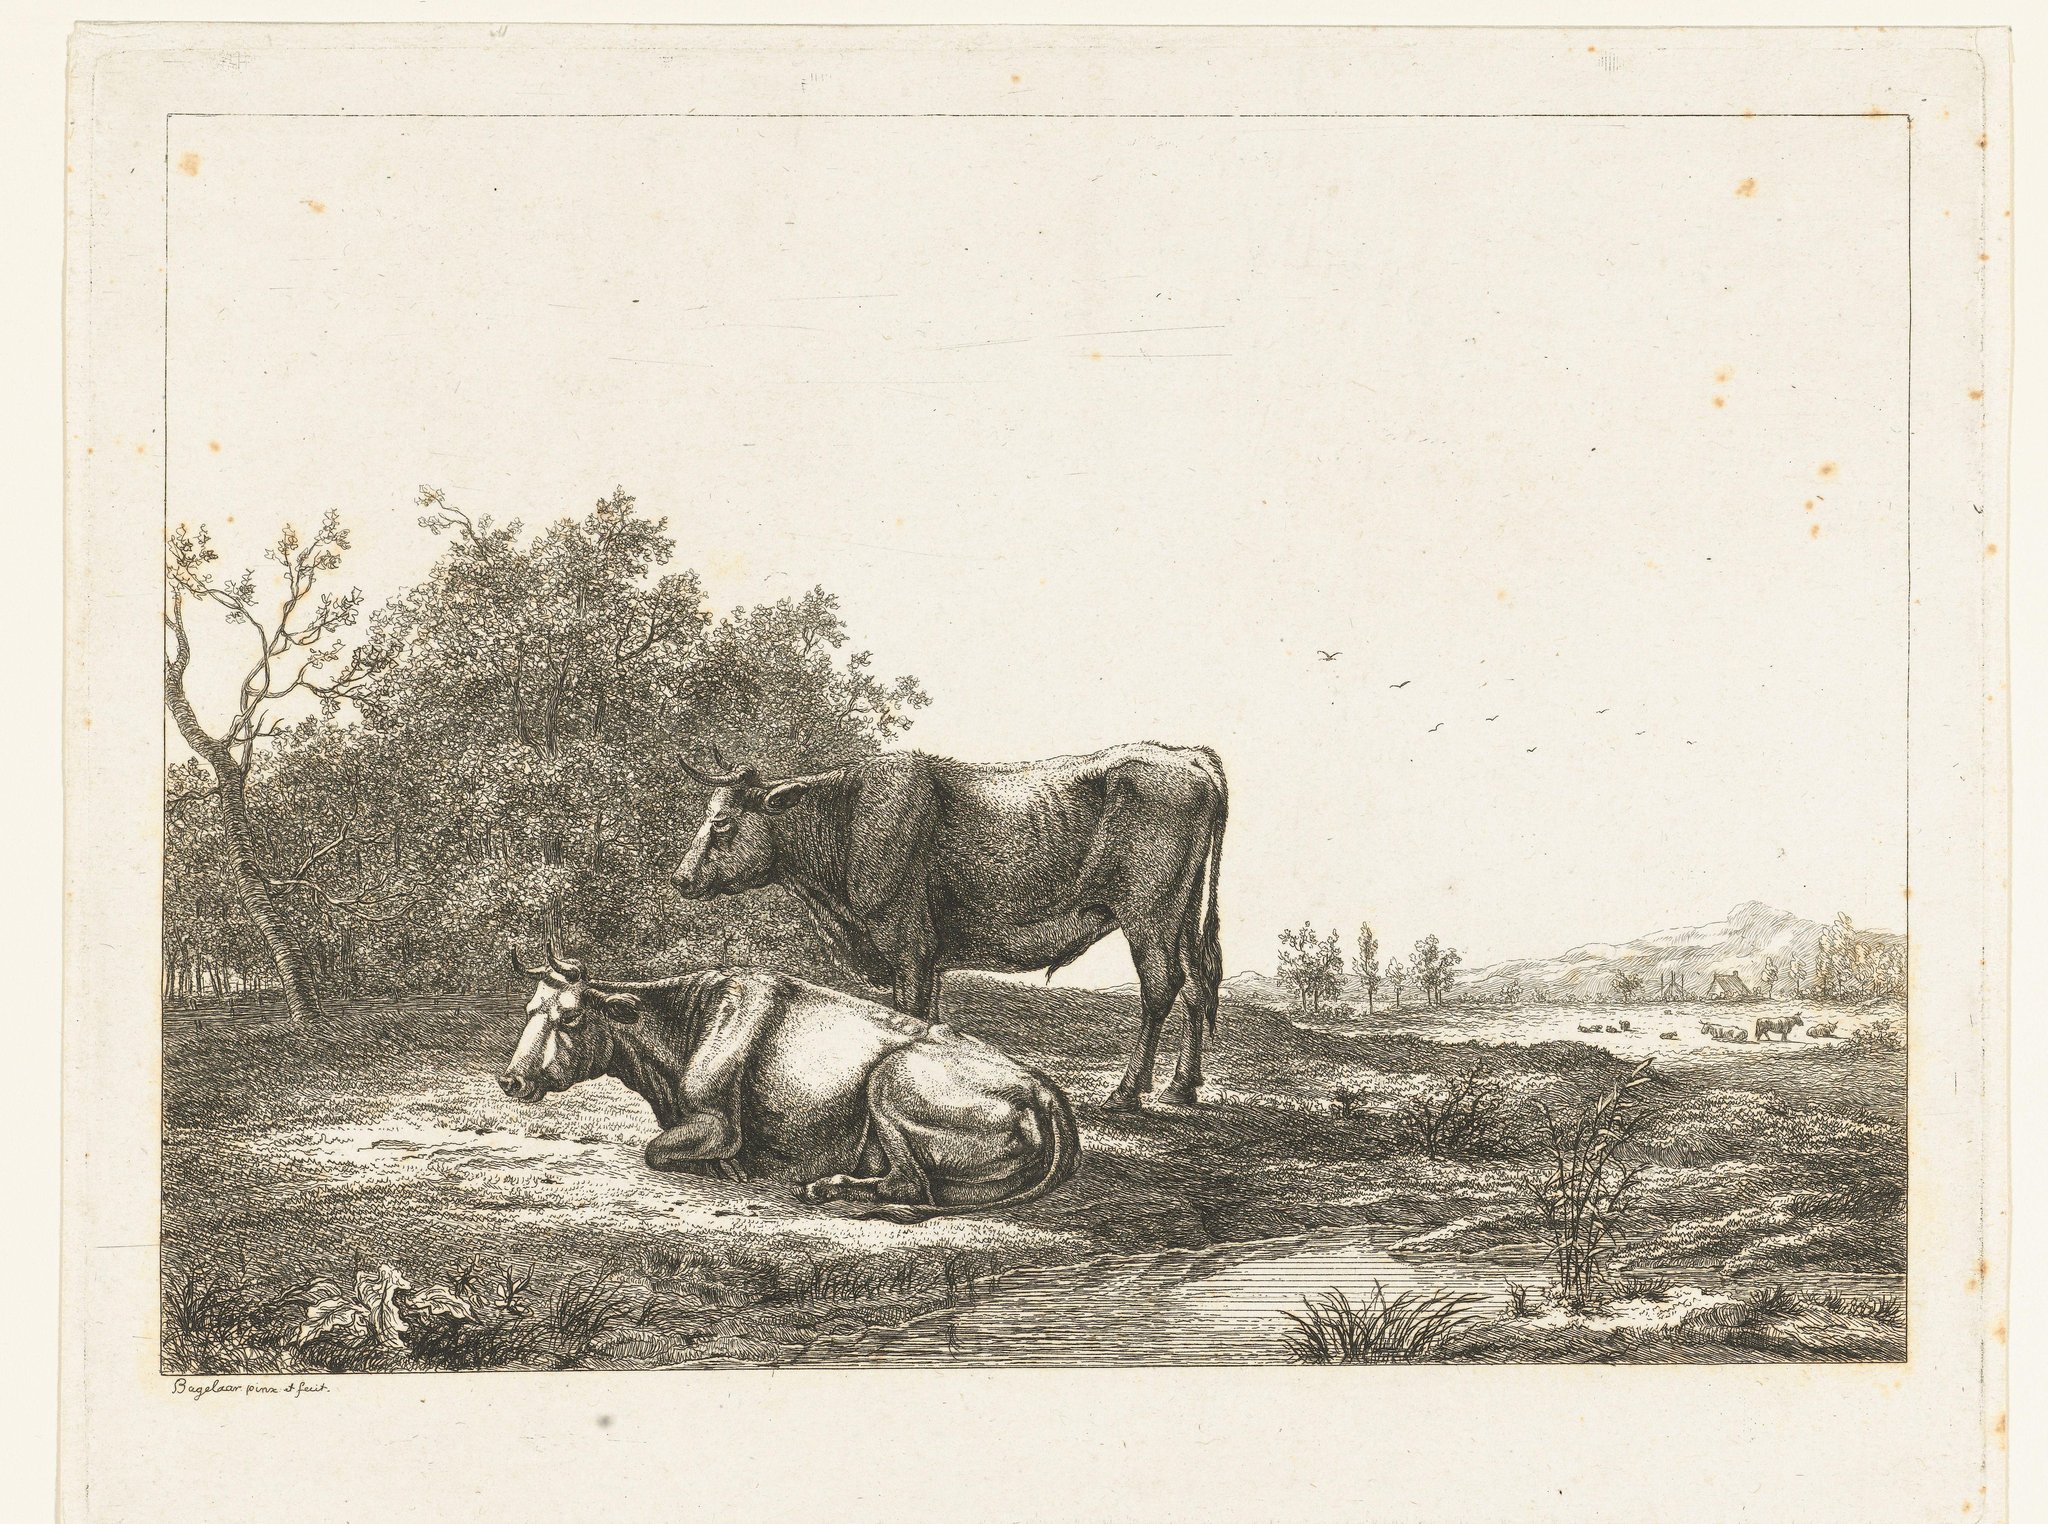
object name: print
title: Een stier en een koe in een weiland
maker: ernst willem jan bagelaar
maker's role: draughtsman, print maker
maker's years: 1775-1837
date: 1798-1837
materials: paper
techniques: etching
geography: netherlands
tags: bovine cattle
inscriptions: collector's mark: Lugt 2228